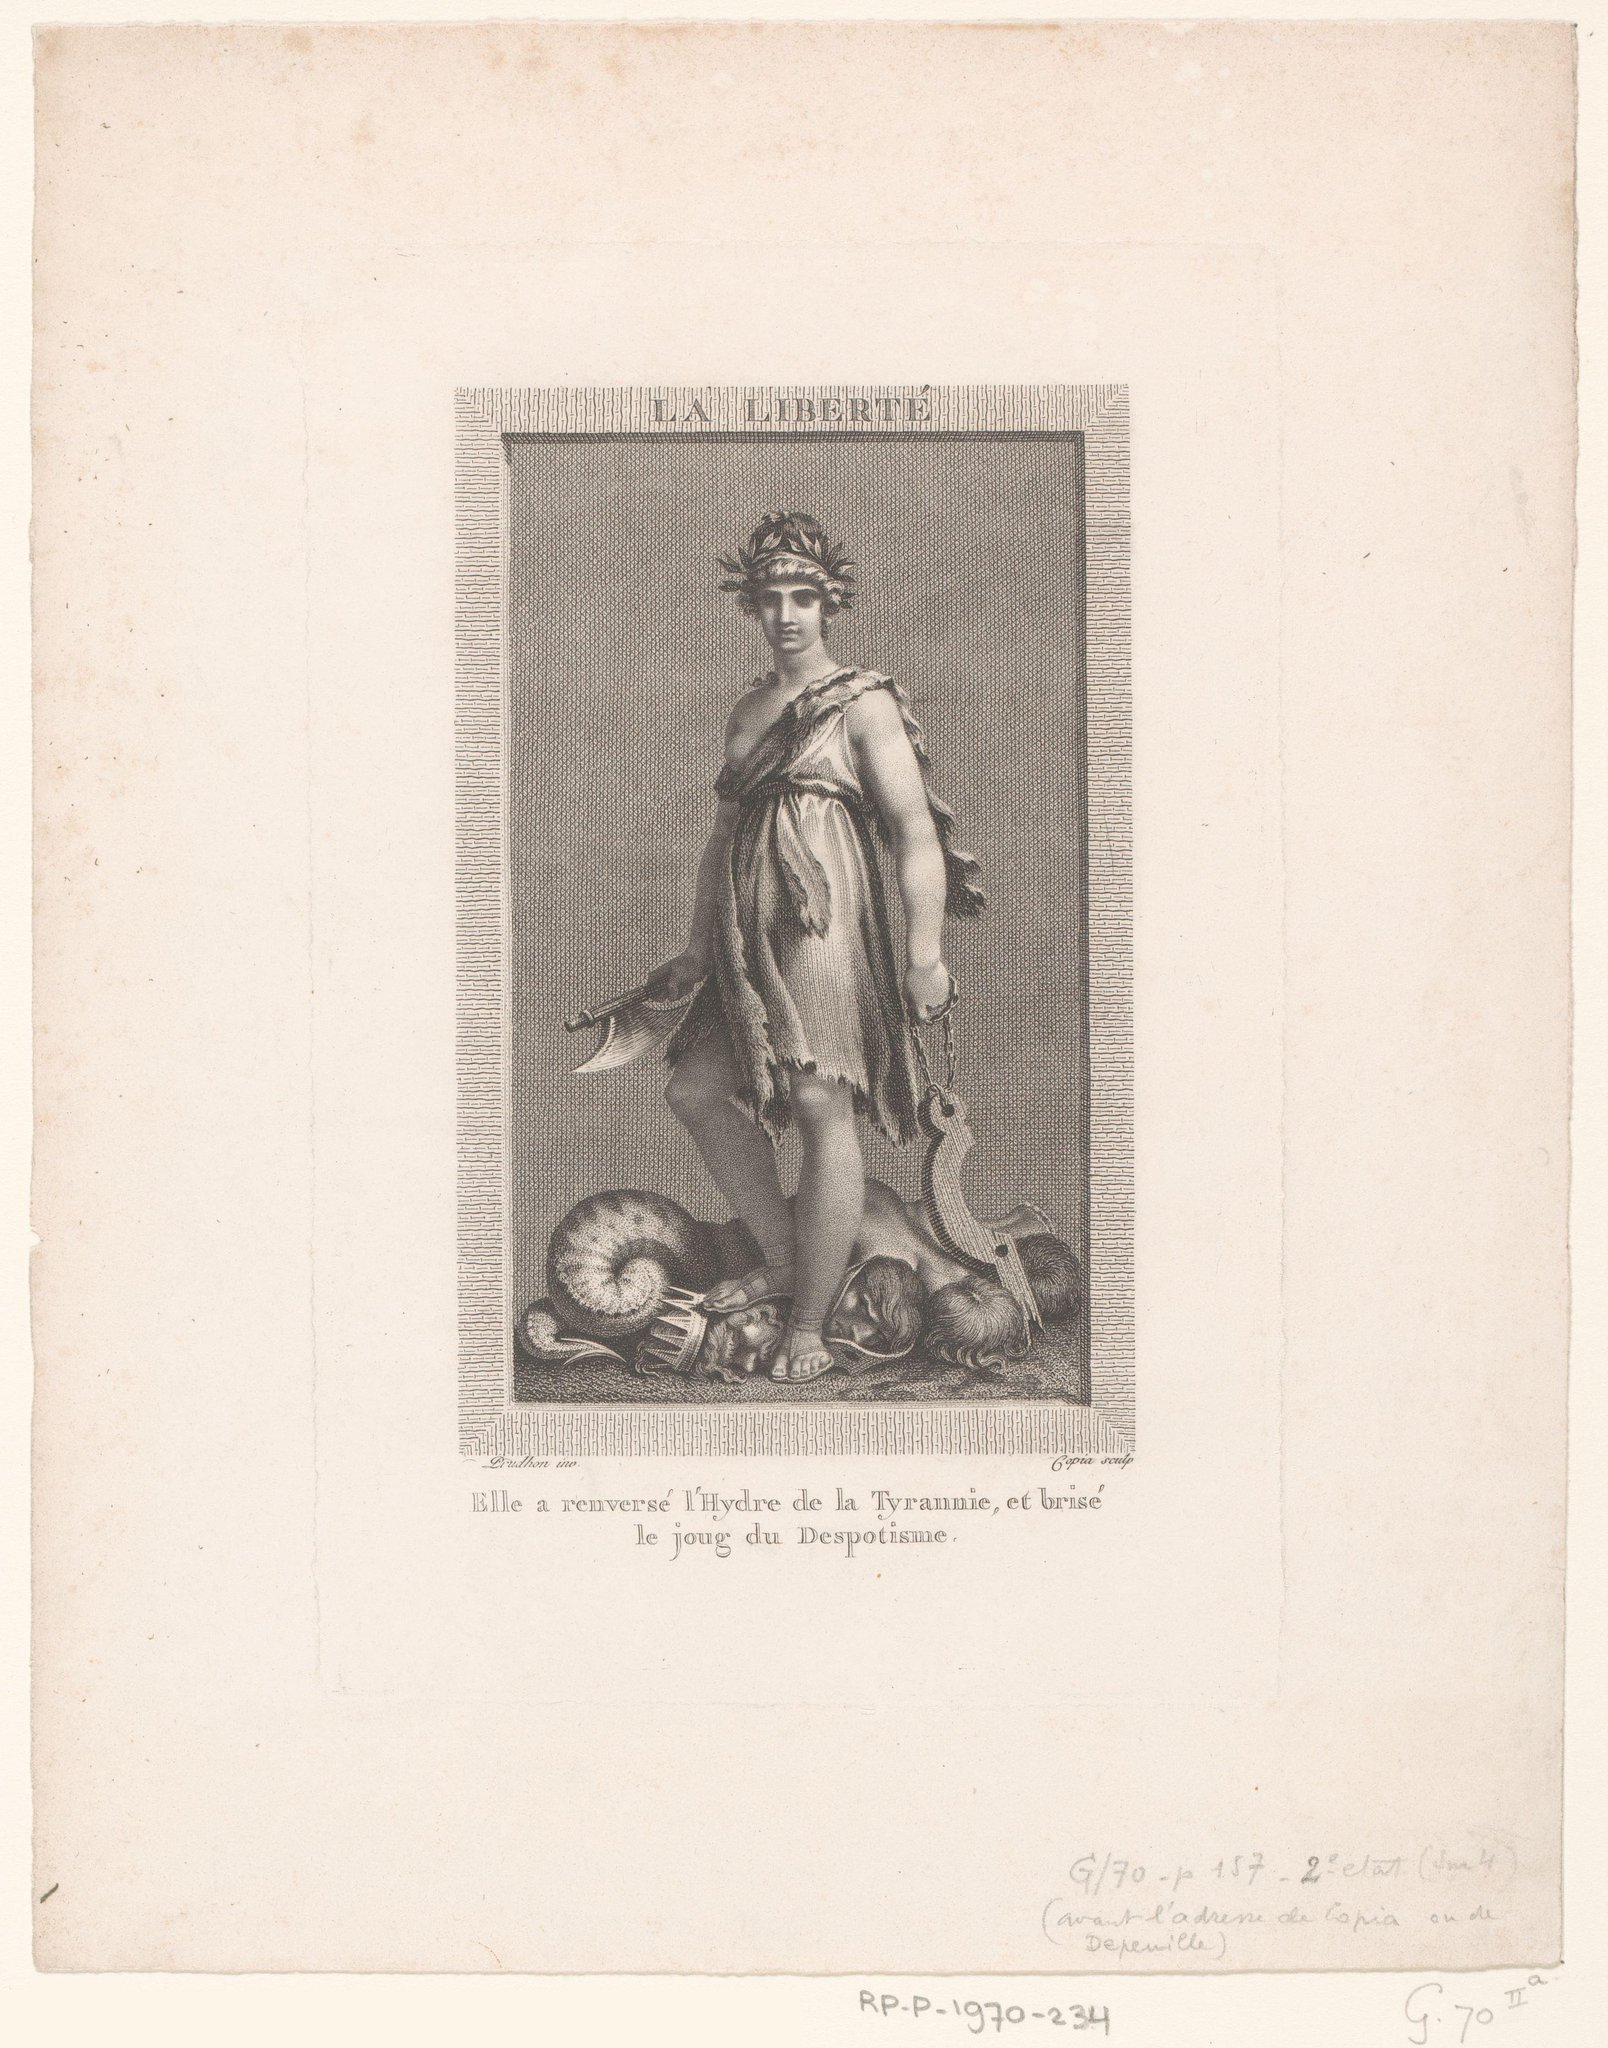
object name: print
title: Vrijheid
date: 1793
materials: paper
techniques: engraving, etching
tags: attributes of hercules (with name), libertas as roman personification, freedom, liberty; 'libertà' (ripa), yoke, 'hydra'; 'hidra' (ripa), dictatorial government, tyranny; 'tirannide' (ripa)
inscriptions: collector's mark: Lugt 2760, collector's mark: Lugt 2228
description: Vrijheid heeft de hydra van de tirannie verslagen en het juk van despotisme gebroken.